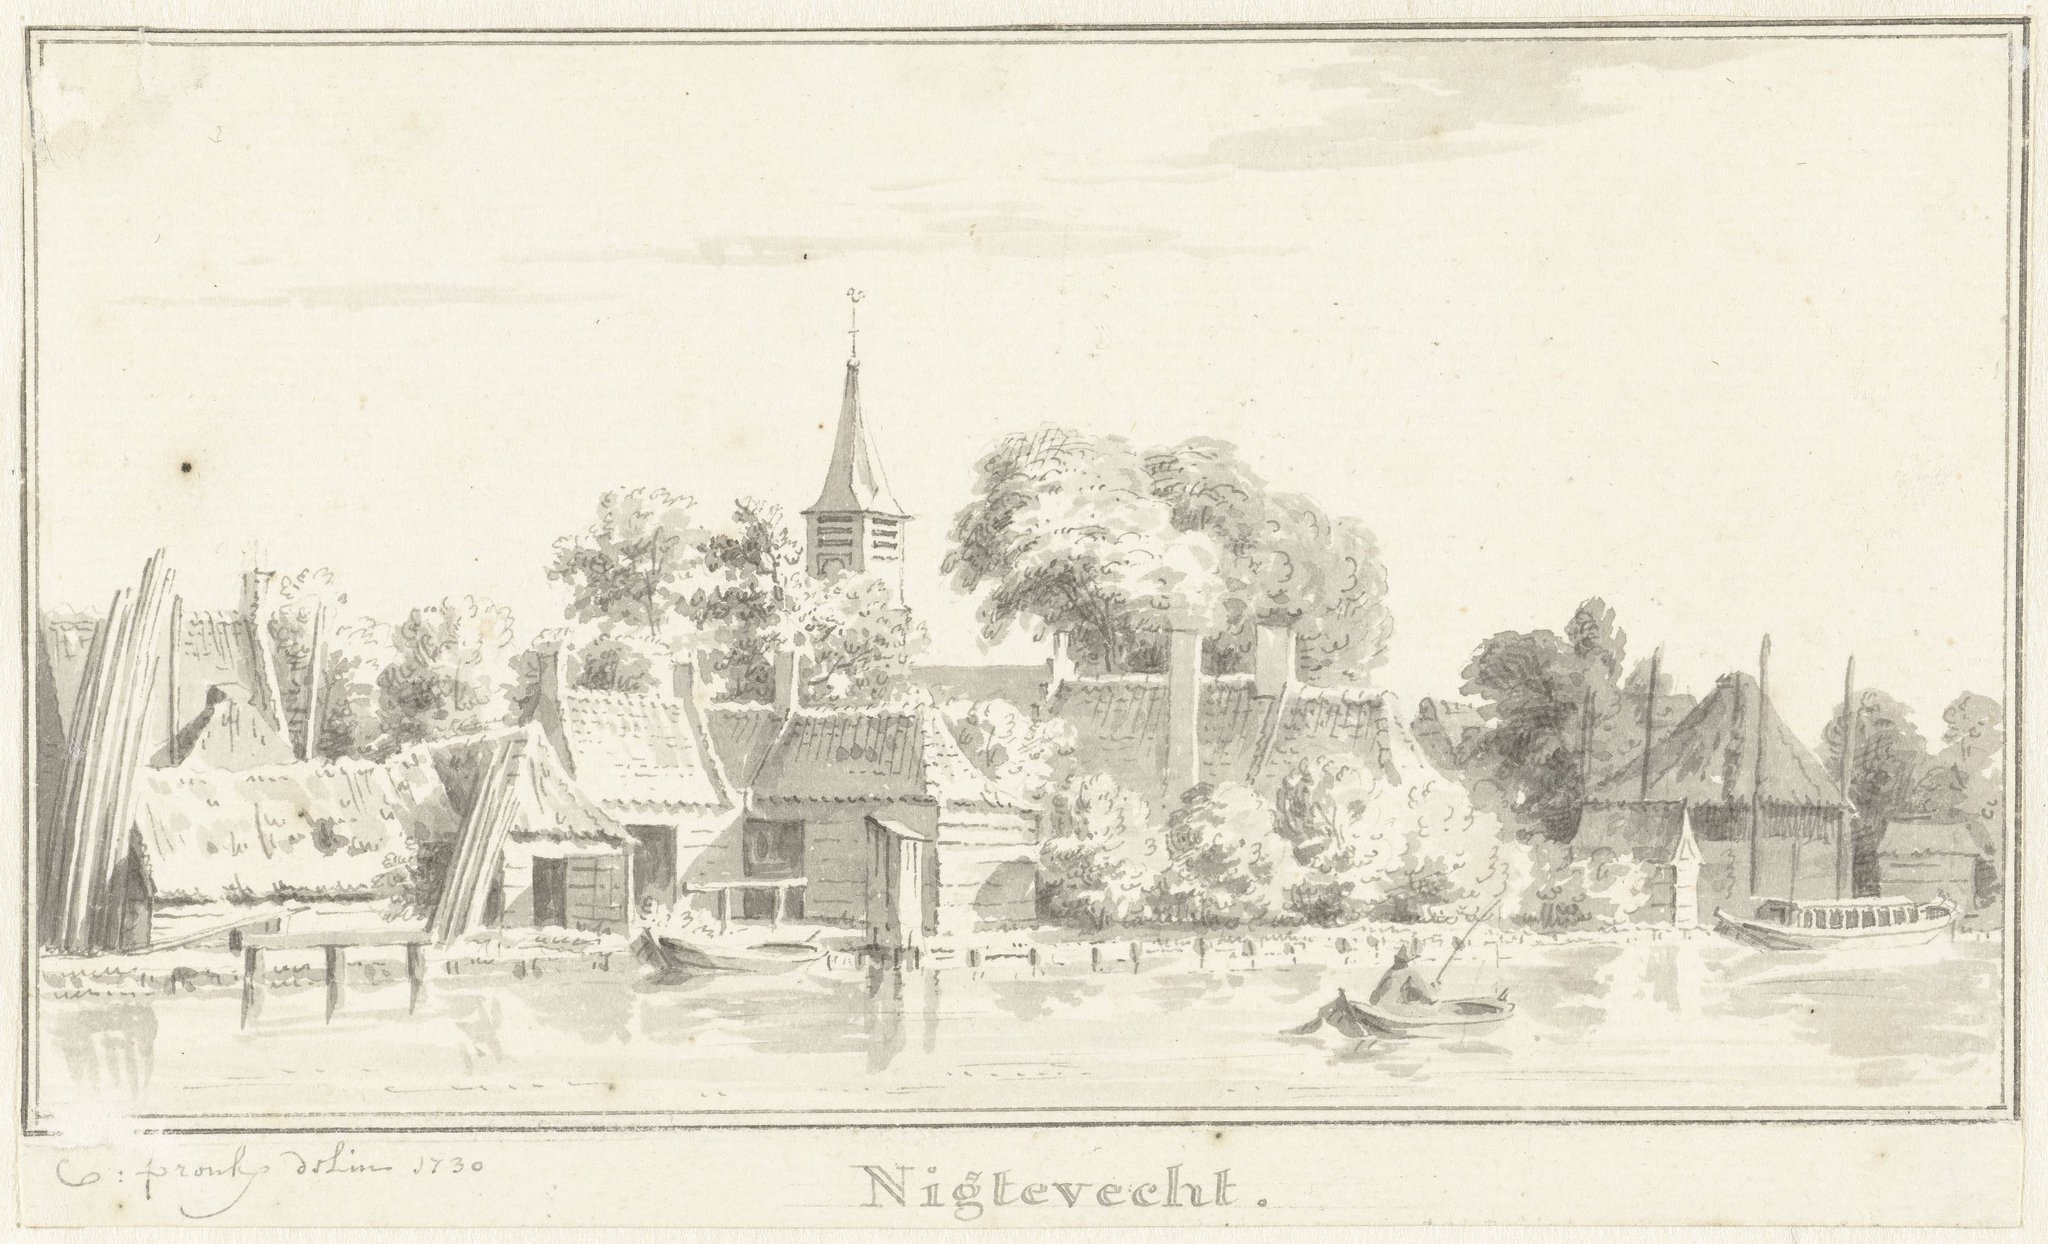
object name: drawing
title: Gezicht op Nigtevecht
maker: cornelis pronk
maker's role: draughtsman, painter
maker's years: 1691-1759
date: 1730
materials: ink, paper, pencil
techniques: brush, pen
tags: city-view, and landscape with man-made constructions